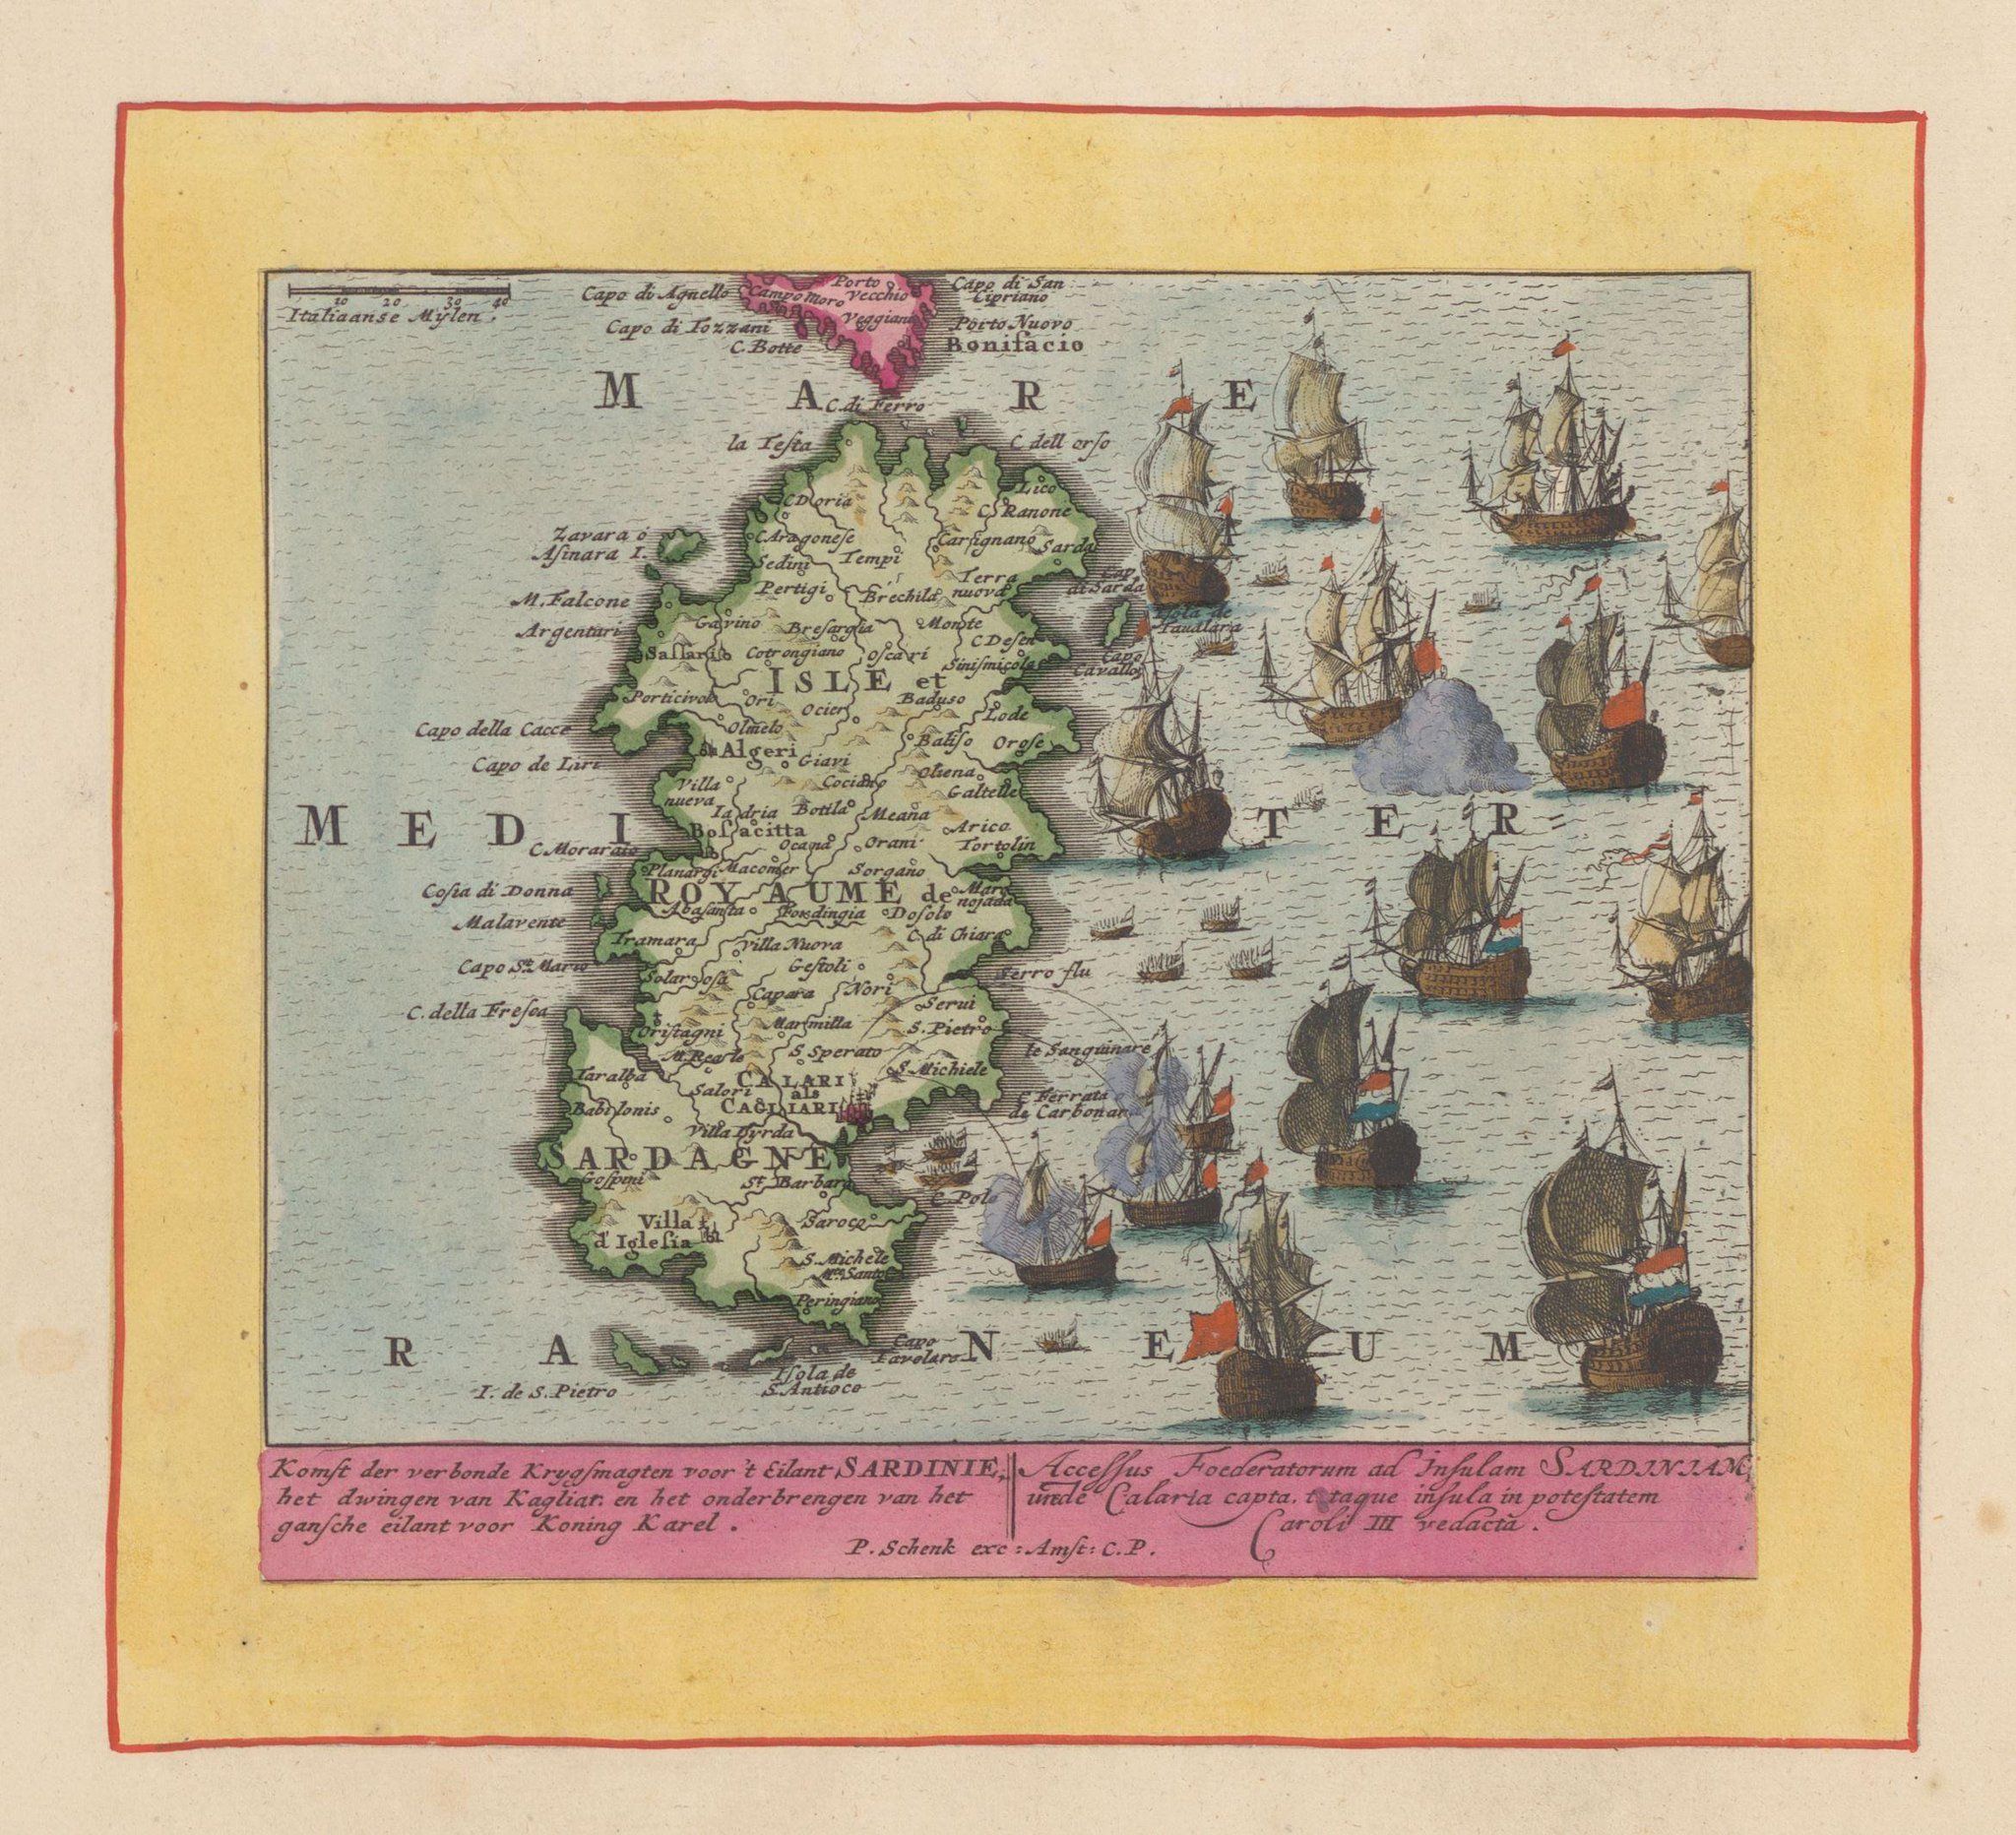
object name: album leaf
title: Schouwburg van den Oorlog, Beginnende van Koning Karel den II. Tot op Koning Karel den III. Bestaande in IX. Historische Figuren op een Olifants Blad, als Veldslagen, Belegeringen te Water en te Lande, met de voornaamste Vestingen (...)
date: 1707-1720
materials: paper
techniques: etching, hand coloring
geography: amsterdam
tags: maps of separate countries or regions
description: Prent uit: Schouwburg van den oorlog, beginnende van Karel den II. tot op koning Karel den III. : bestaande in IX historische figuren op een olifants blad, als veldslagen, belegeringen te water en te lande, met de voornaamste vestingen. Amsterdam: Pieter Schenk, 1709.